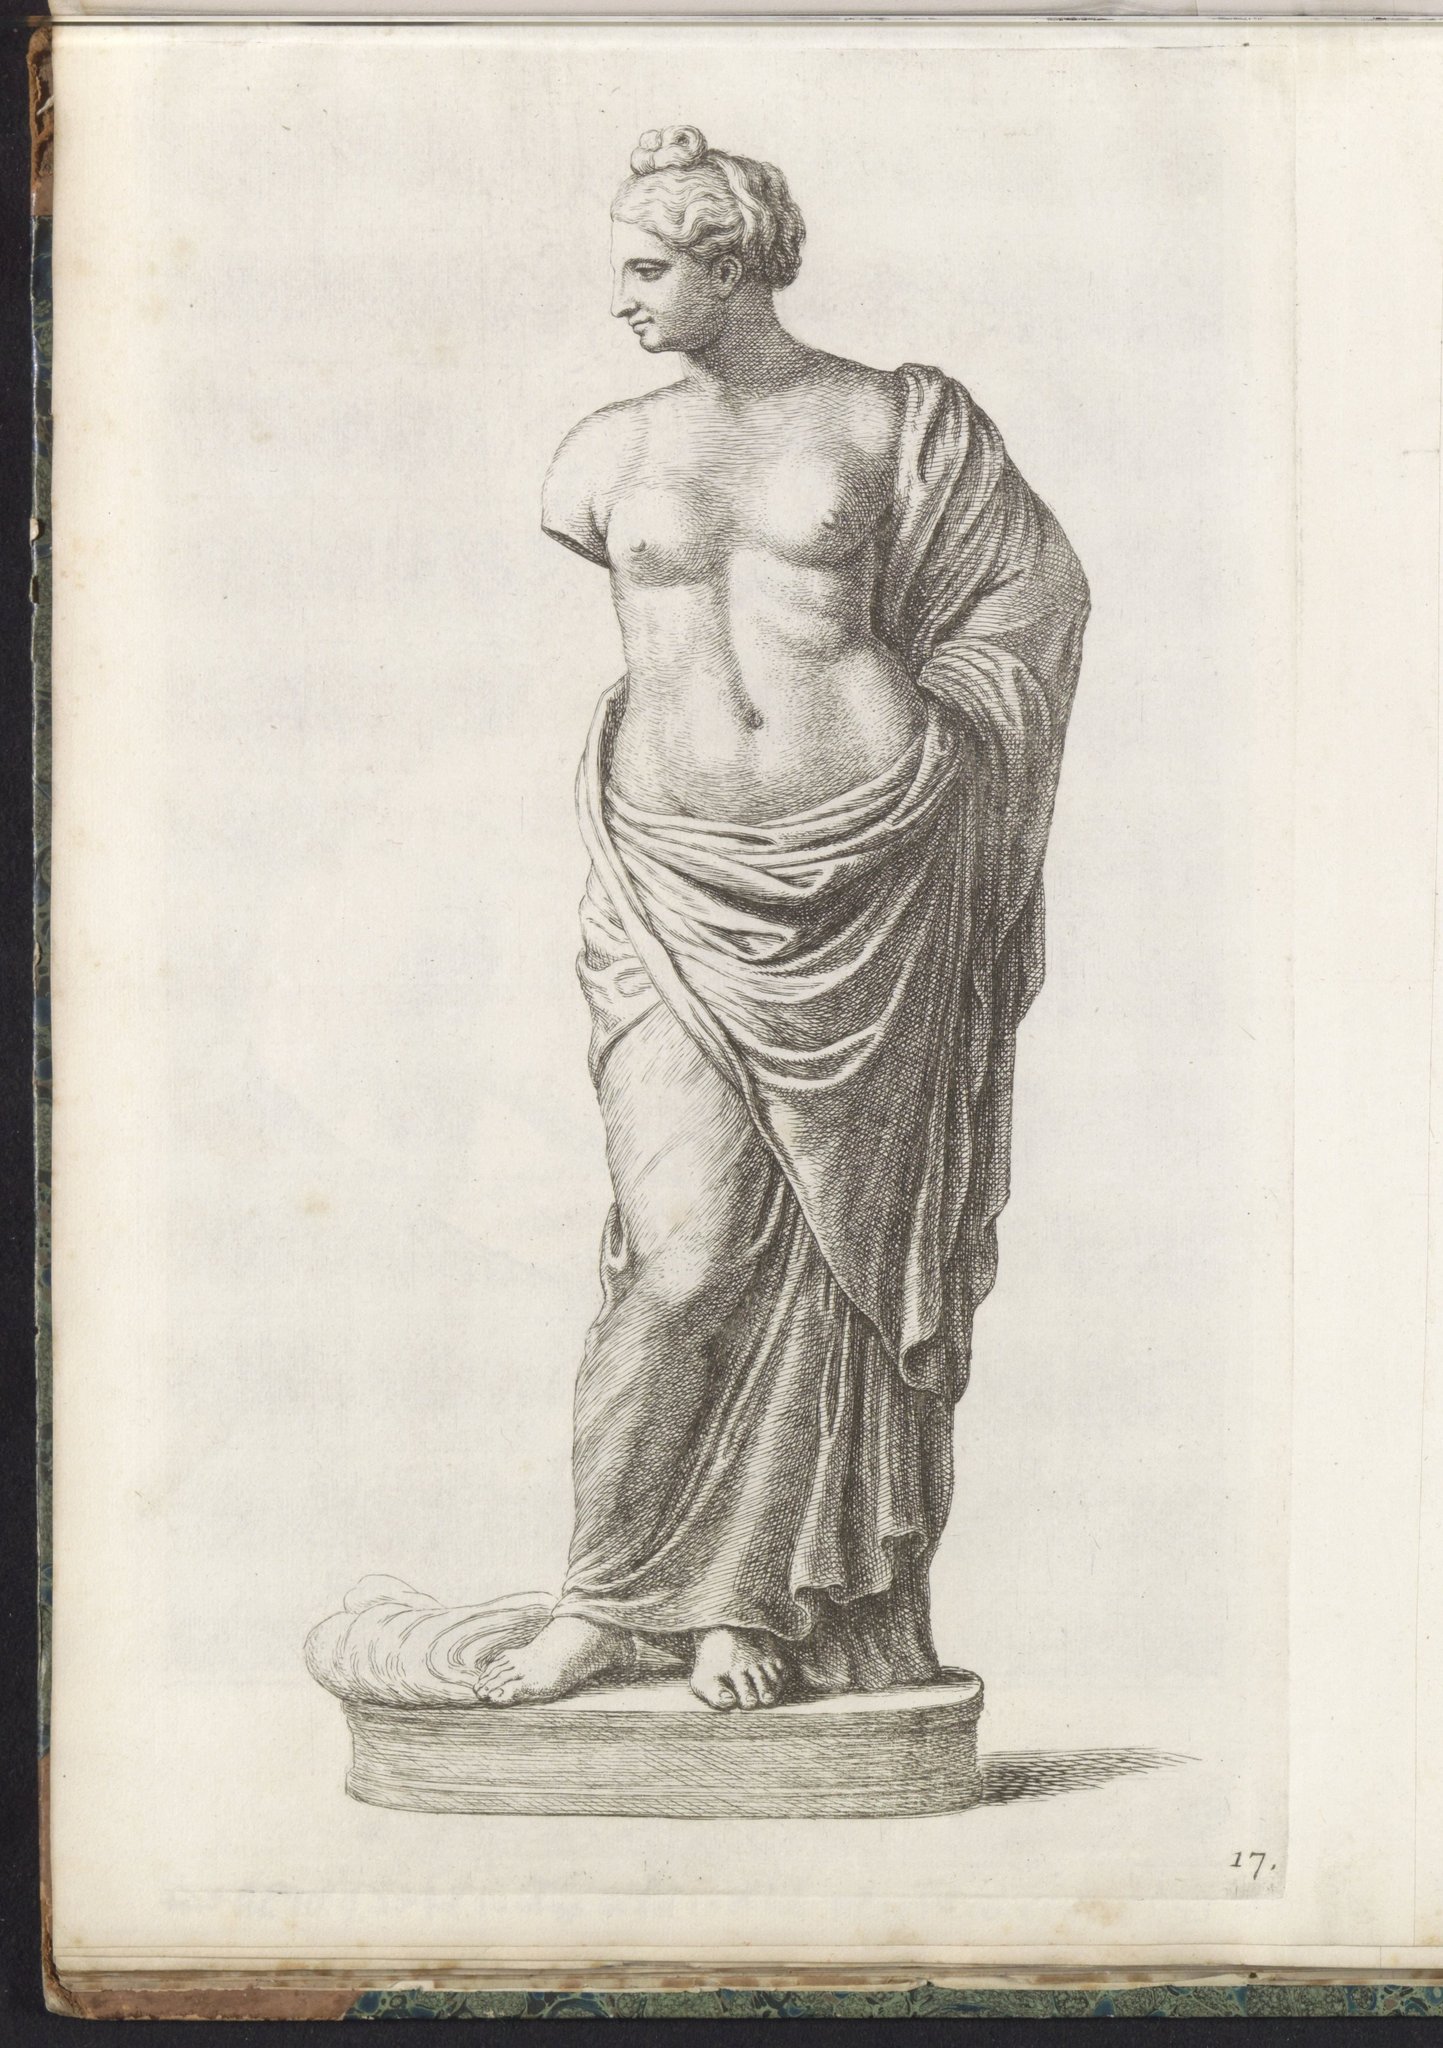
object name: print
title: Sculptuur van een staande vrouw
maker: hubert quellinus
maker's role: print maker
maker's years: 1619-1687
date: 1646-1670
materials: paper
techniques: engraving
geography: antwerp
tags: piece of sculpture, reproduction of a piece of sculpture, standing figure - aa - female human figure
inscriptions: number: ‘48’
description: Klassieke sculptuur van een staande vrouw met ontbloot bovenlichaam. De prent maakt deel uit van een album met een serie prenten naar de sculpturen in de verzameling van Gerard Reynst.